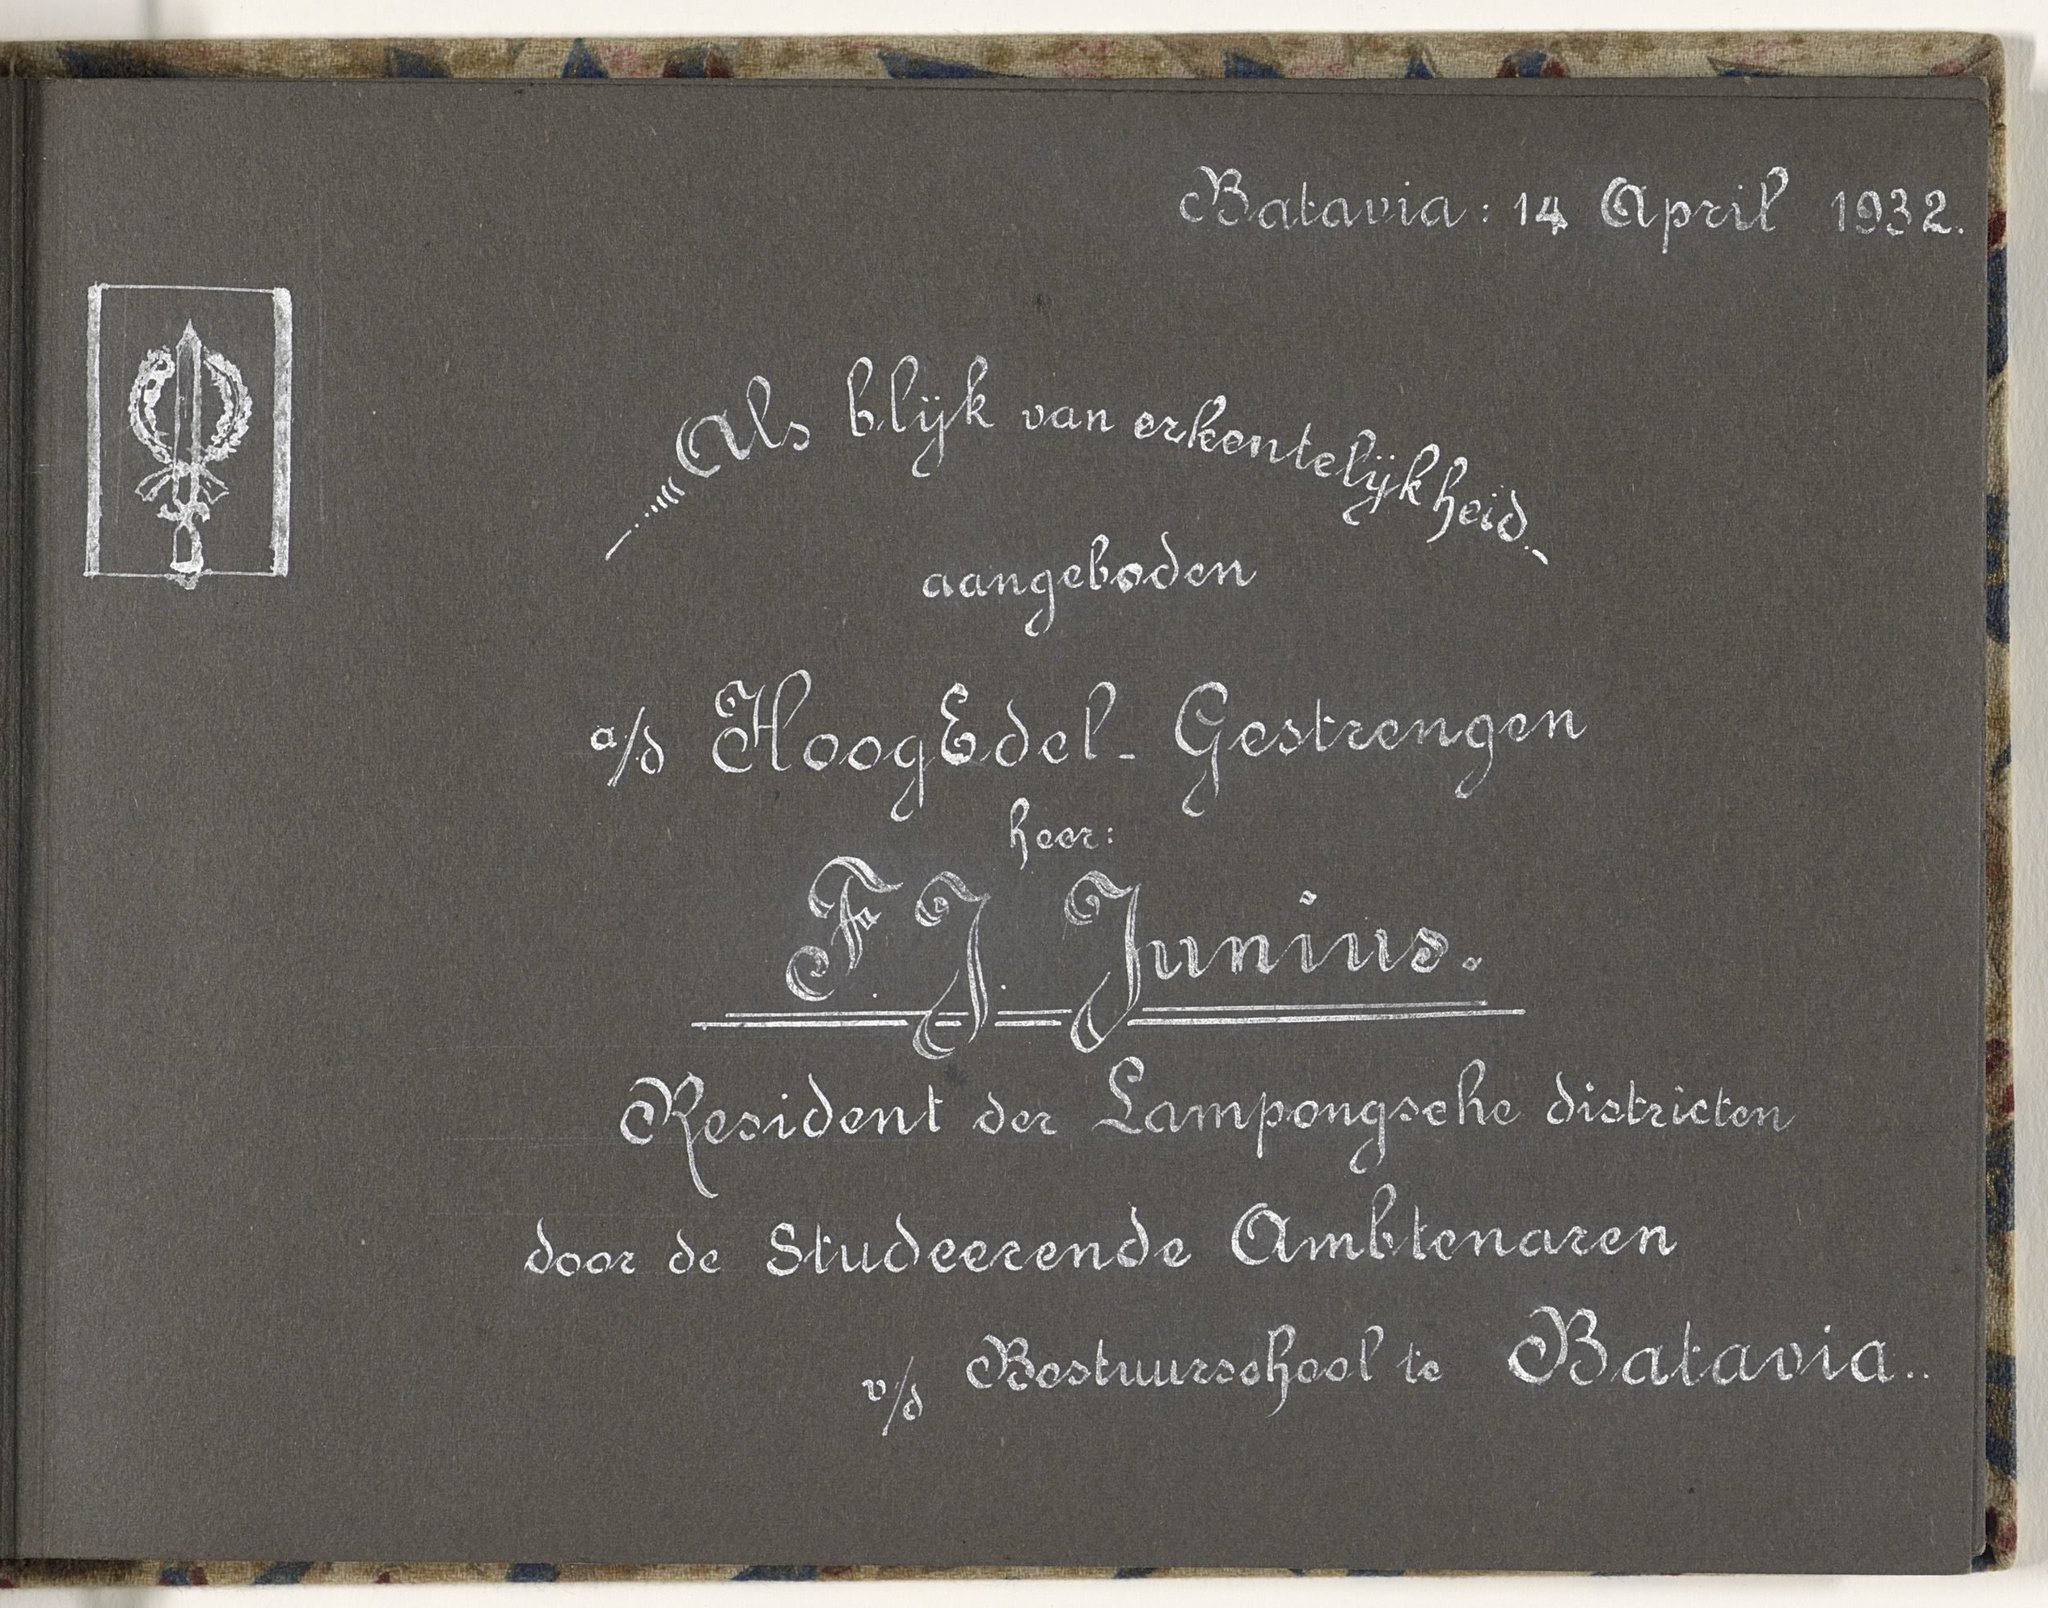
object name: album leaf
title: Titelblad van het fotoalbum aangeboden aan de resident der Lampongse districten F.J. Junius door studerende ambtenaren van de bestuursschool te Batavia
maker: Anonymous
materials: cardboard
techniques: drawing, writing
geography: dutch east indies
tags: dutch east indies, the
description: Titelblad met handgeschreven de naam van de ontvanger, de aanbieders, de reden van aanbieding en de datum. Linksboven een getekende krans en zwaard op een rechthoekig veld. Onderdeel van Fotoalbum aangeboden aan de resident der Lampongse districten F.J. Junius door studerende ambtenaren van de bestuursschool te Batavia.